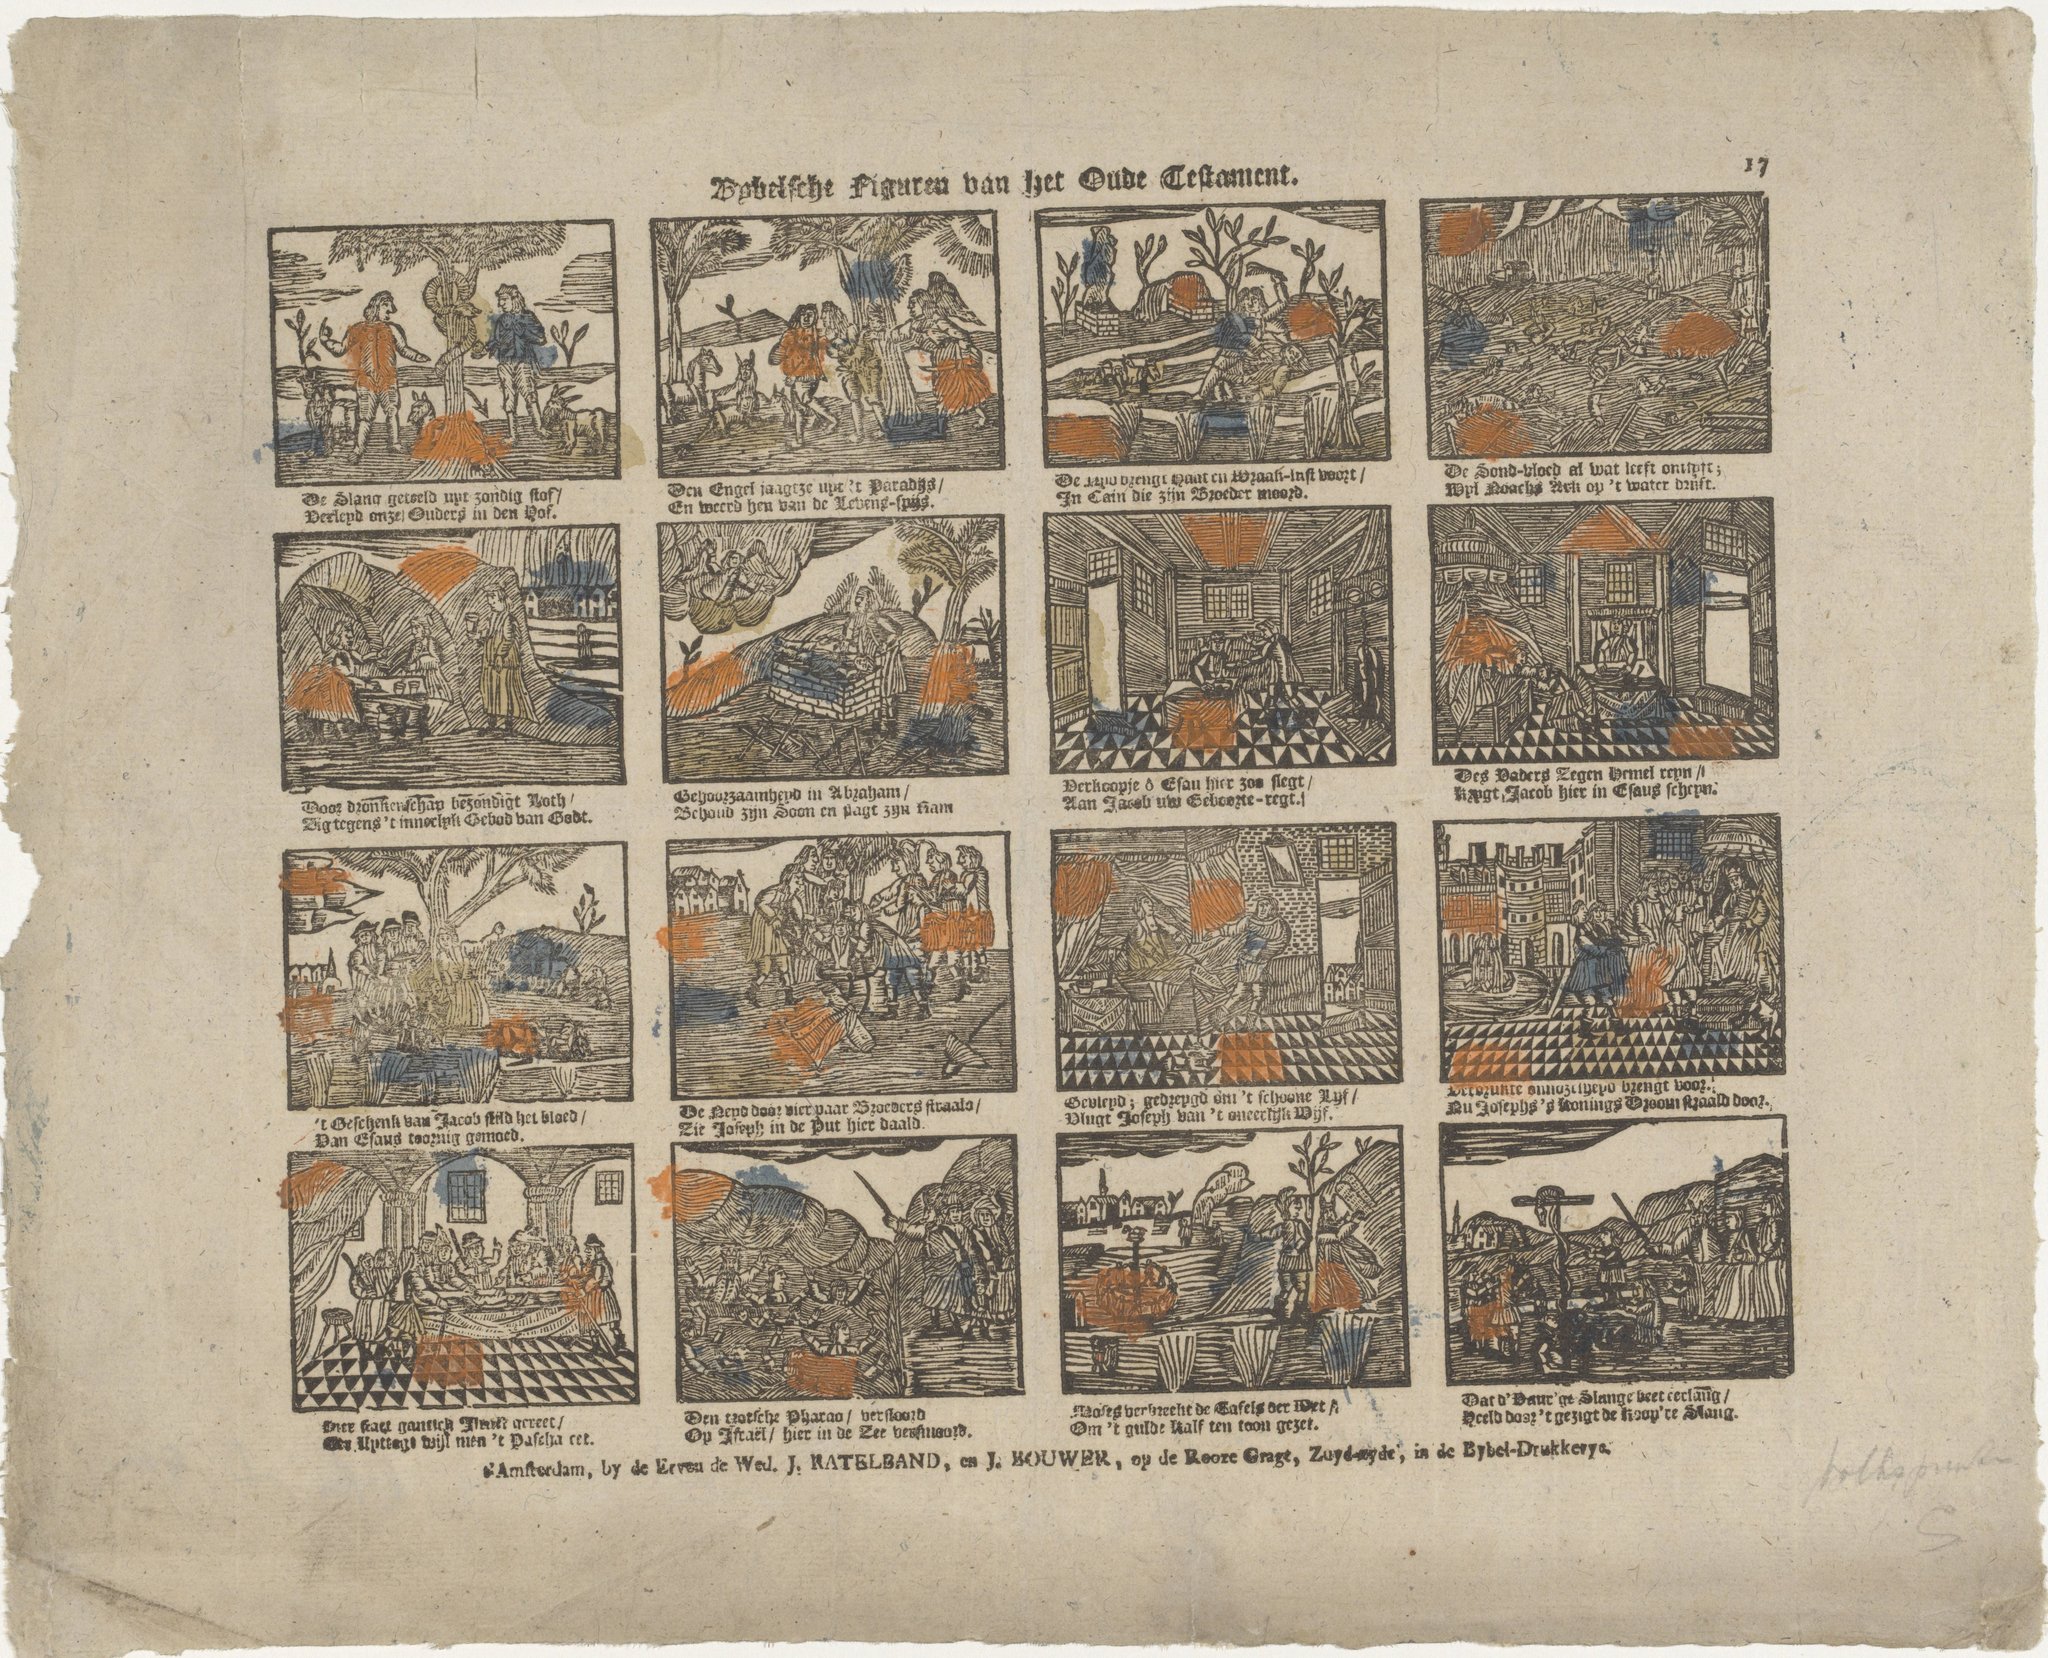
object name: popular print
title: Bybelsche figuren van het Oude Testament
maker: Anonymous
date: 1782-1793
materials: paper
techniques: colour, letterpress printing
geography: amsterdam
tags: old testament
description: Blad met 16 voorstellingen van verhalen uit het Oude Testament. Onder elke afbeelding een tweeregelig vers. Genummerd rechtsboven: 17.